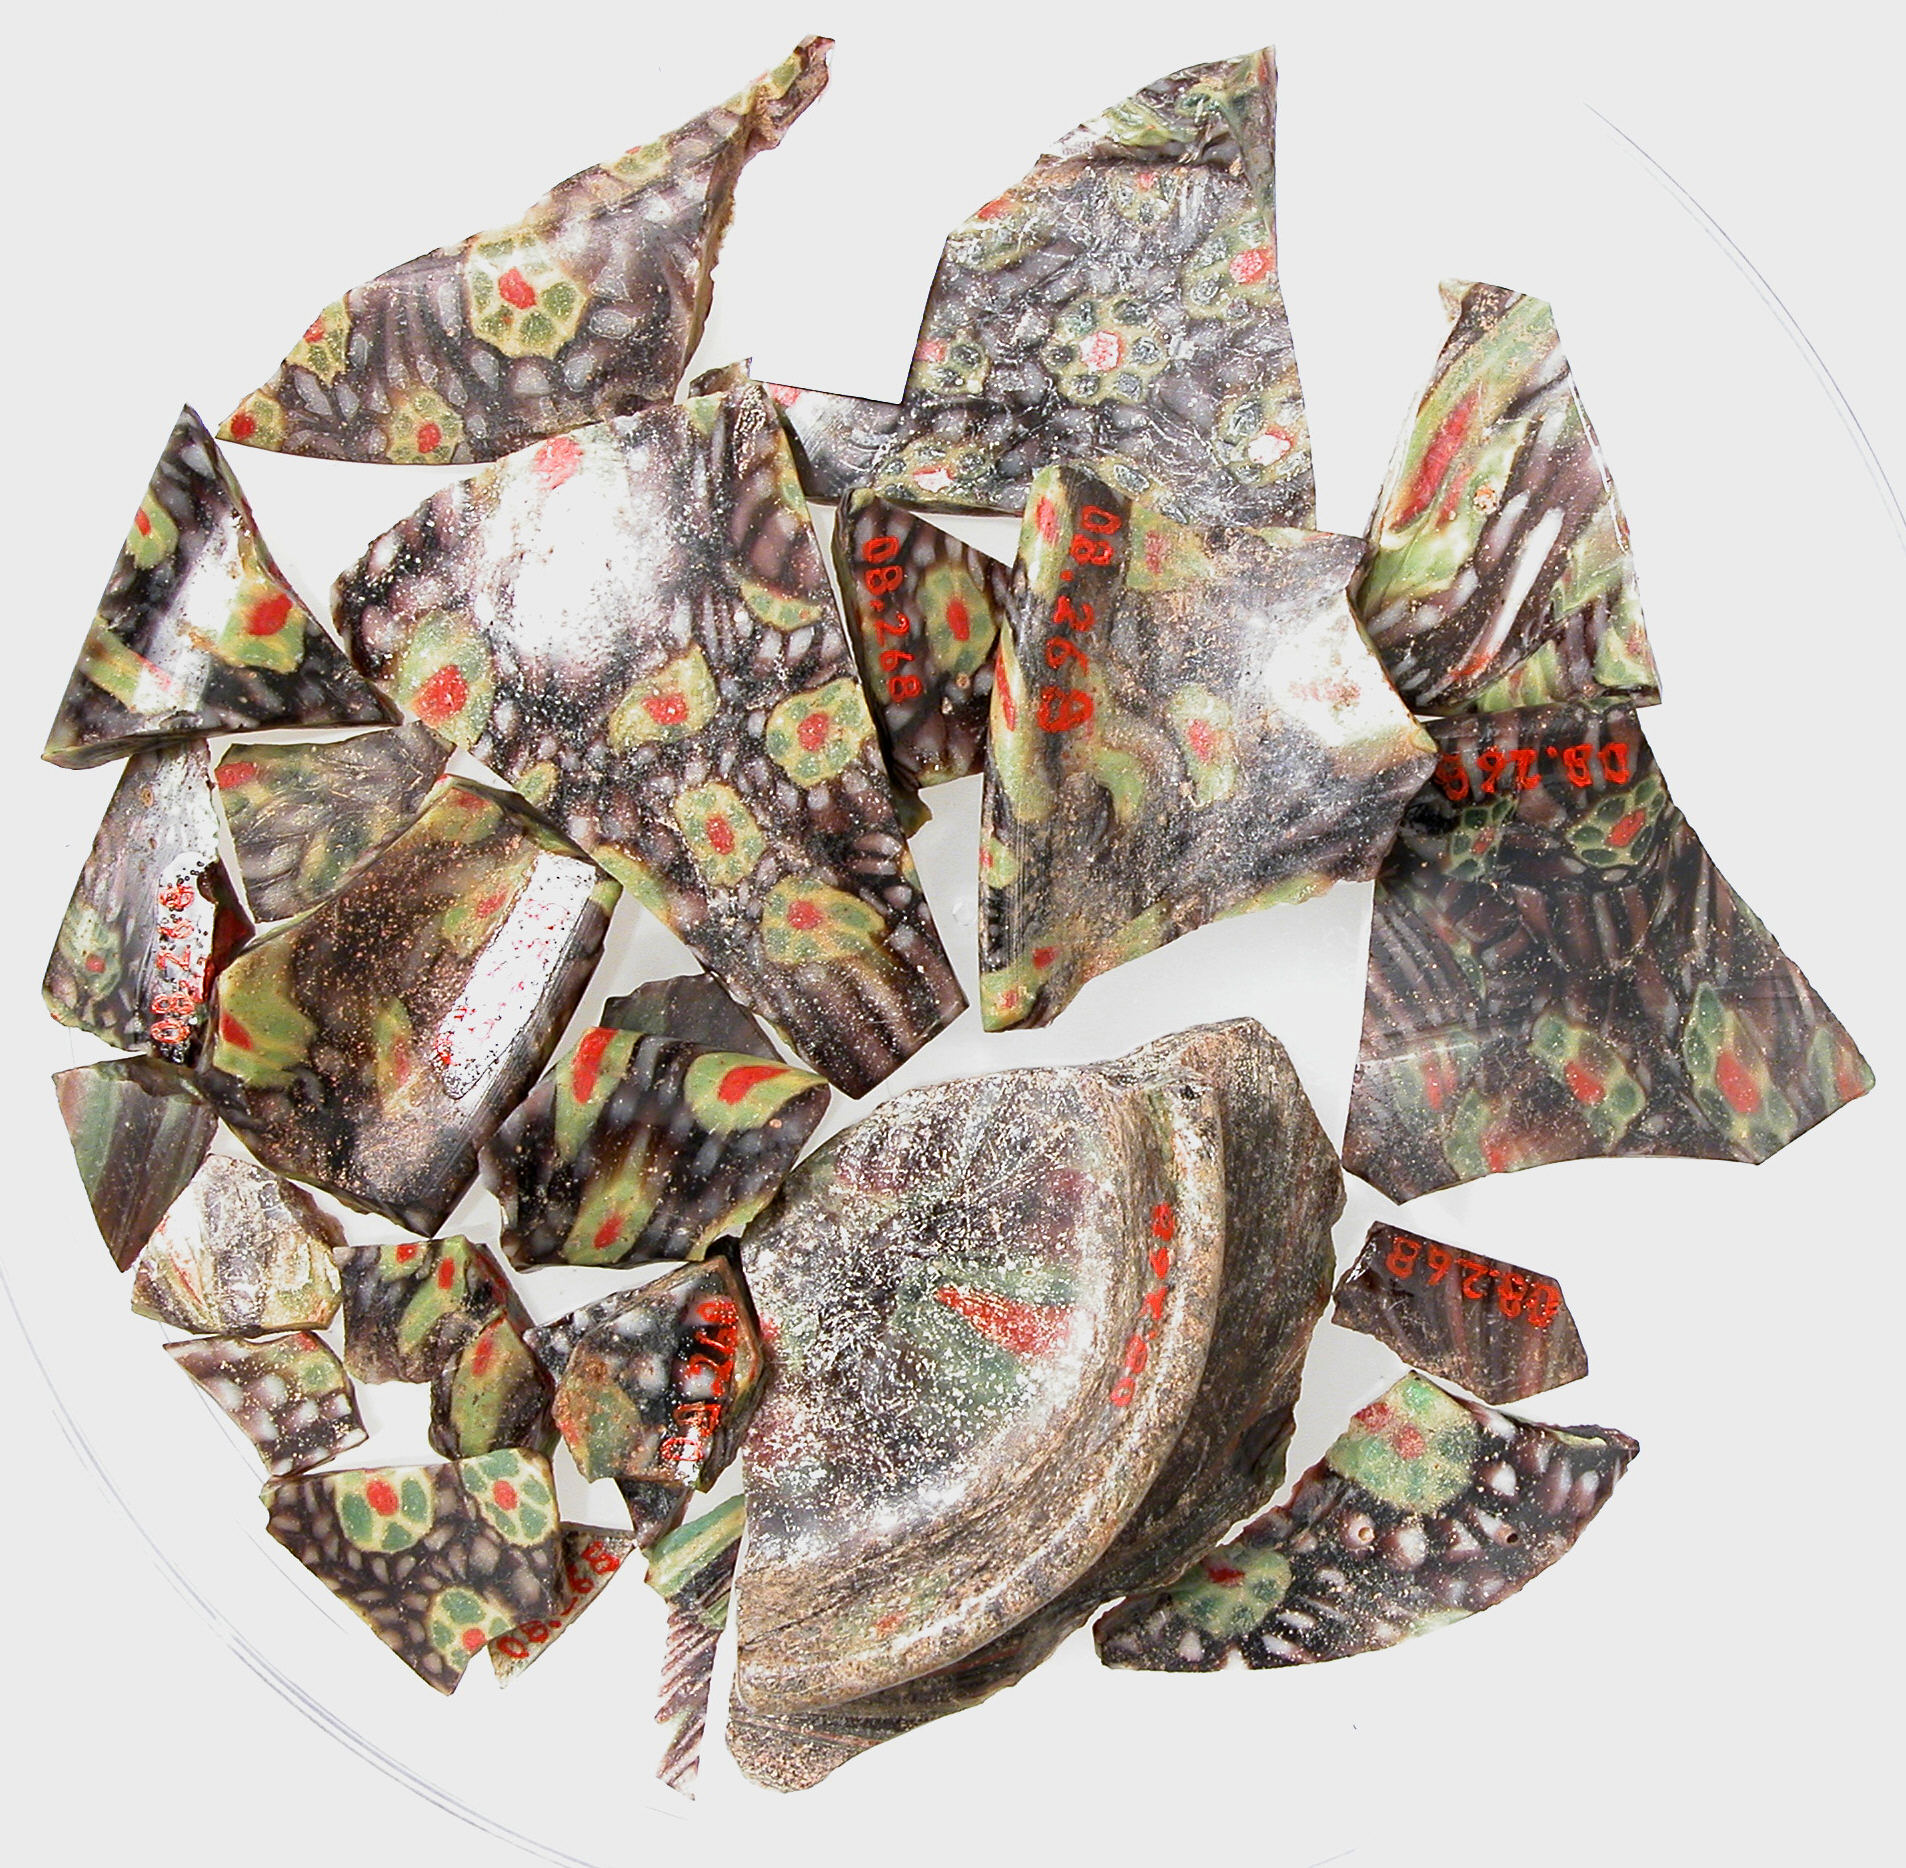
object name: fragment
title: Glass Fragments from a Vessel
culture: coptic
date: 301-433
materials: glass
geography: egypt